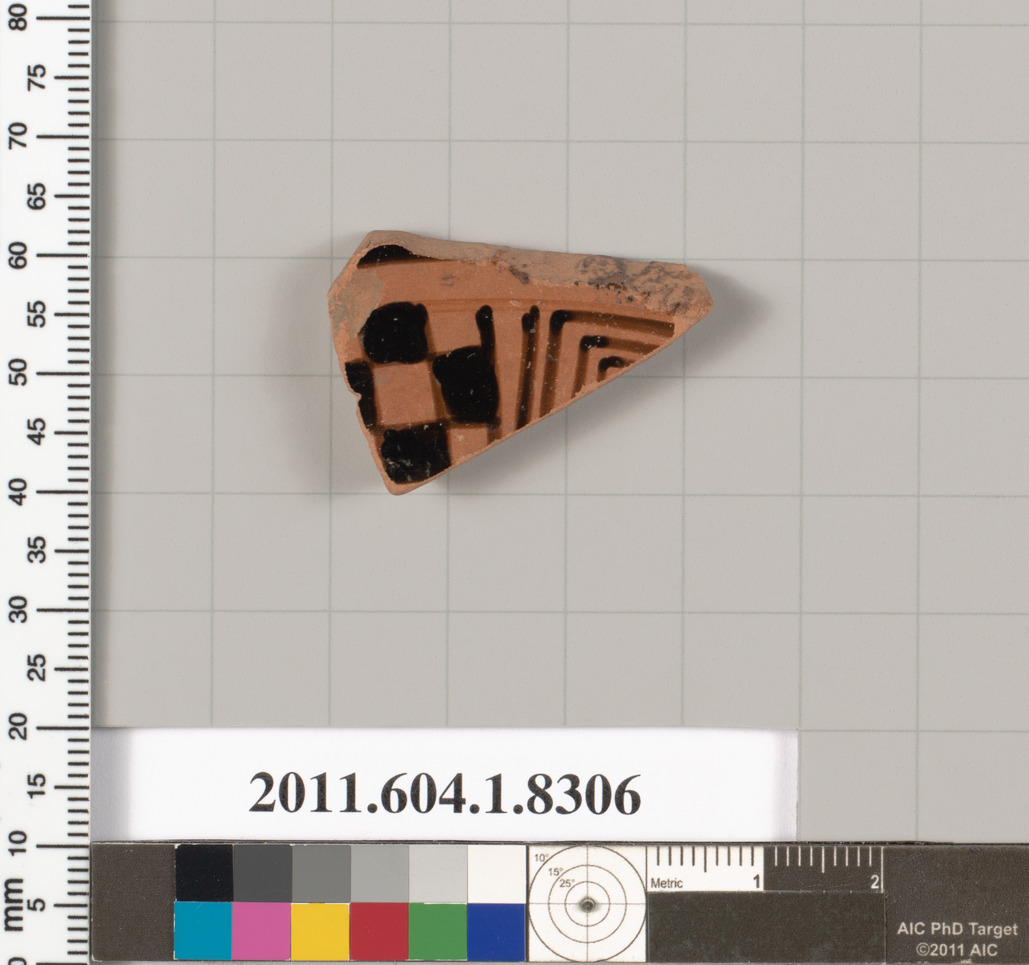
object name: kylix fragment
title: Terracotta fragment of a kylix (drinking cup)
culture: greek, attic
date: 375-351 BCE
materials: terracotta